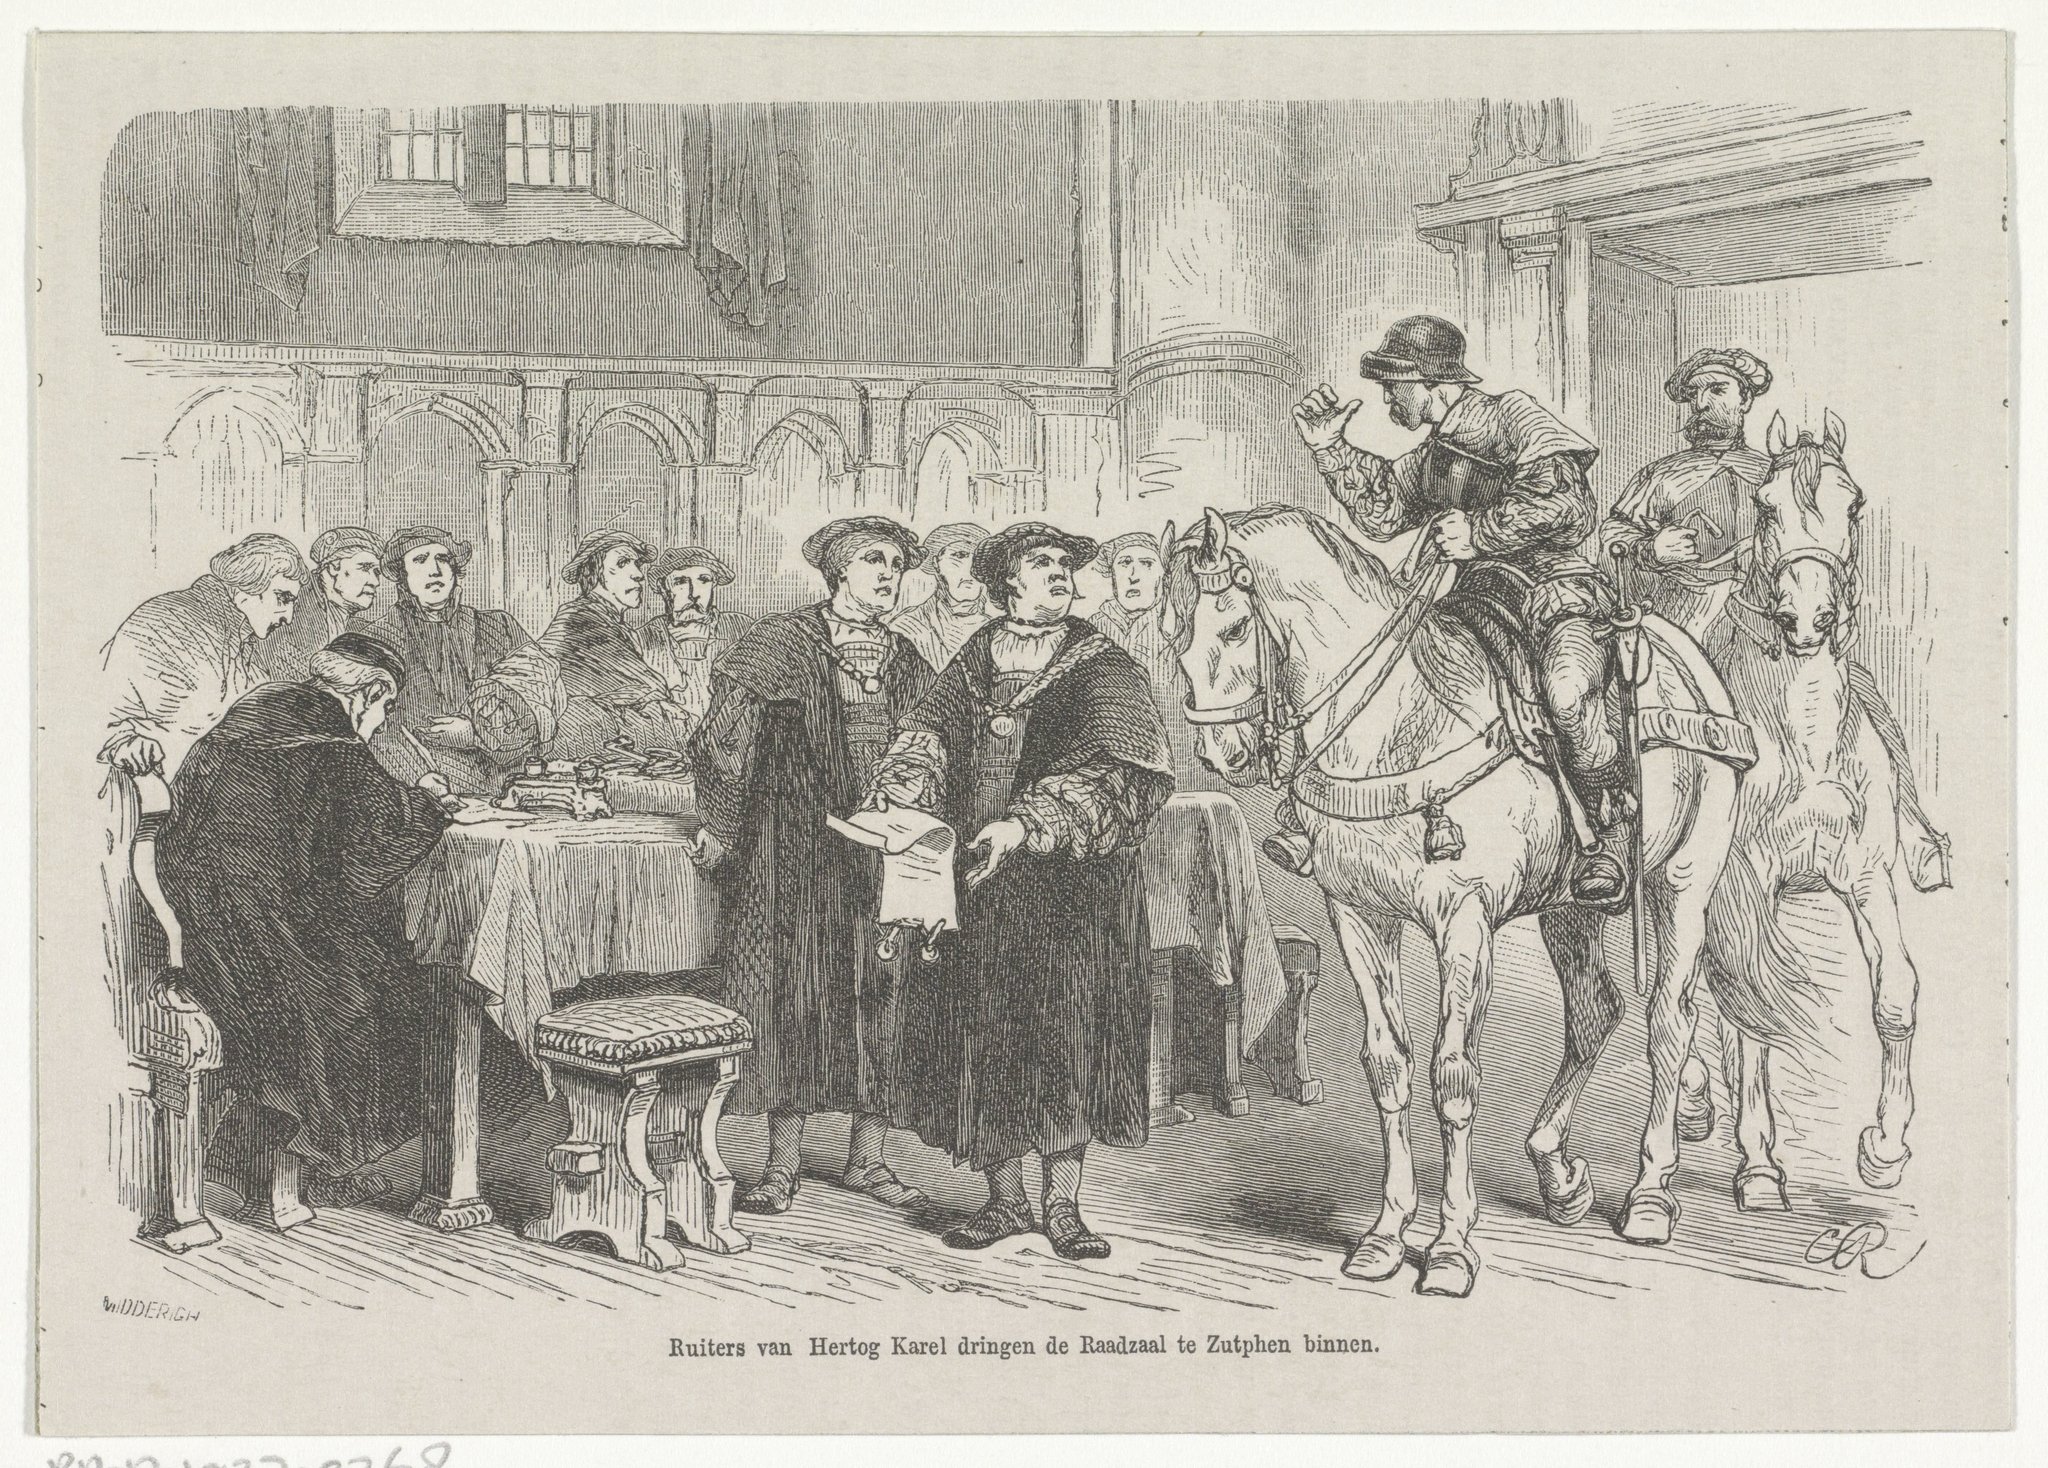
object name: book illustration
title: Ruiters van Hertog Karel dringen de Raadzaal te Zutphen binnen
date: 1833-1890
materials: paper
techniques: letterpress printing, engraving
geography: netherlands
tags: riding a horse, ass, or mule; rider, horseman, mayor, burgomaster, townhall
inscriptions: collector's mark: Lugt 2228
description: De ruiters van hertog Karel hebben de opdracht gekregen niet van hun paarden te stijgen voor zij de burgemeesters en de raad hun hertogelijke lastgeving hebben medegedeeld en rijden te paard het stadhuis van Zutphen binnen.